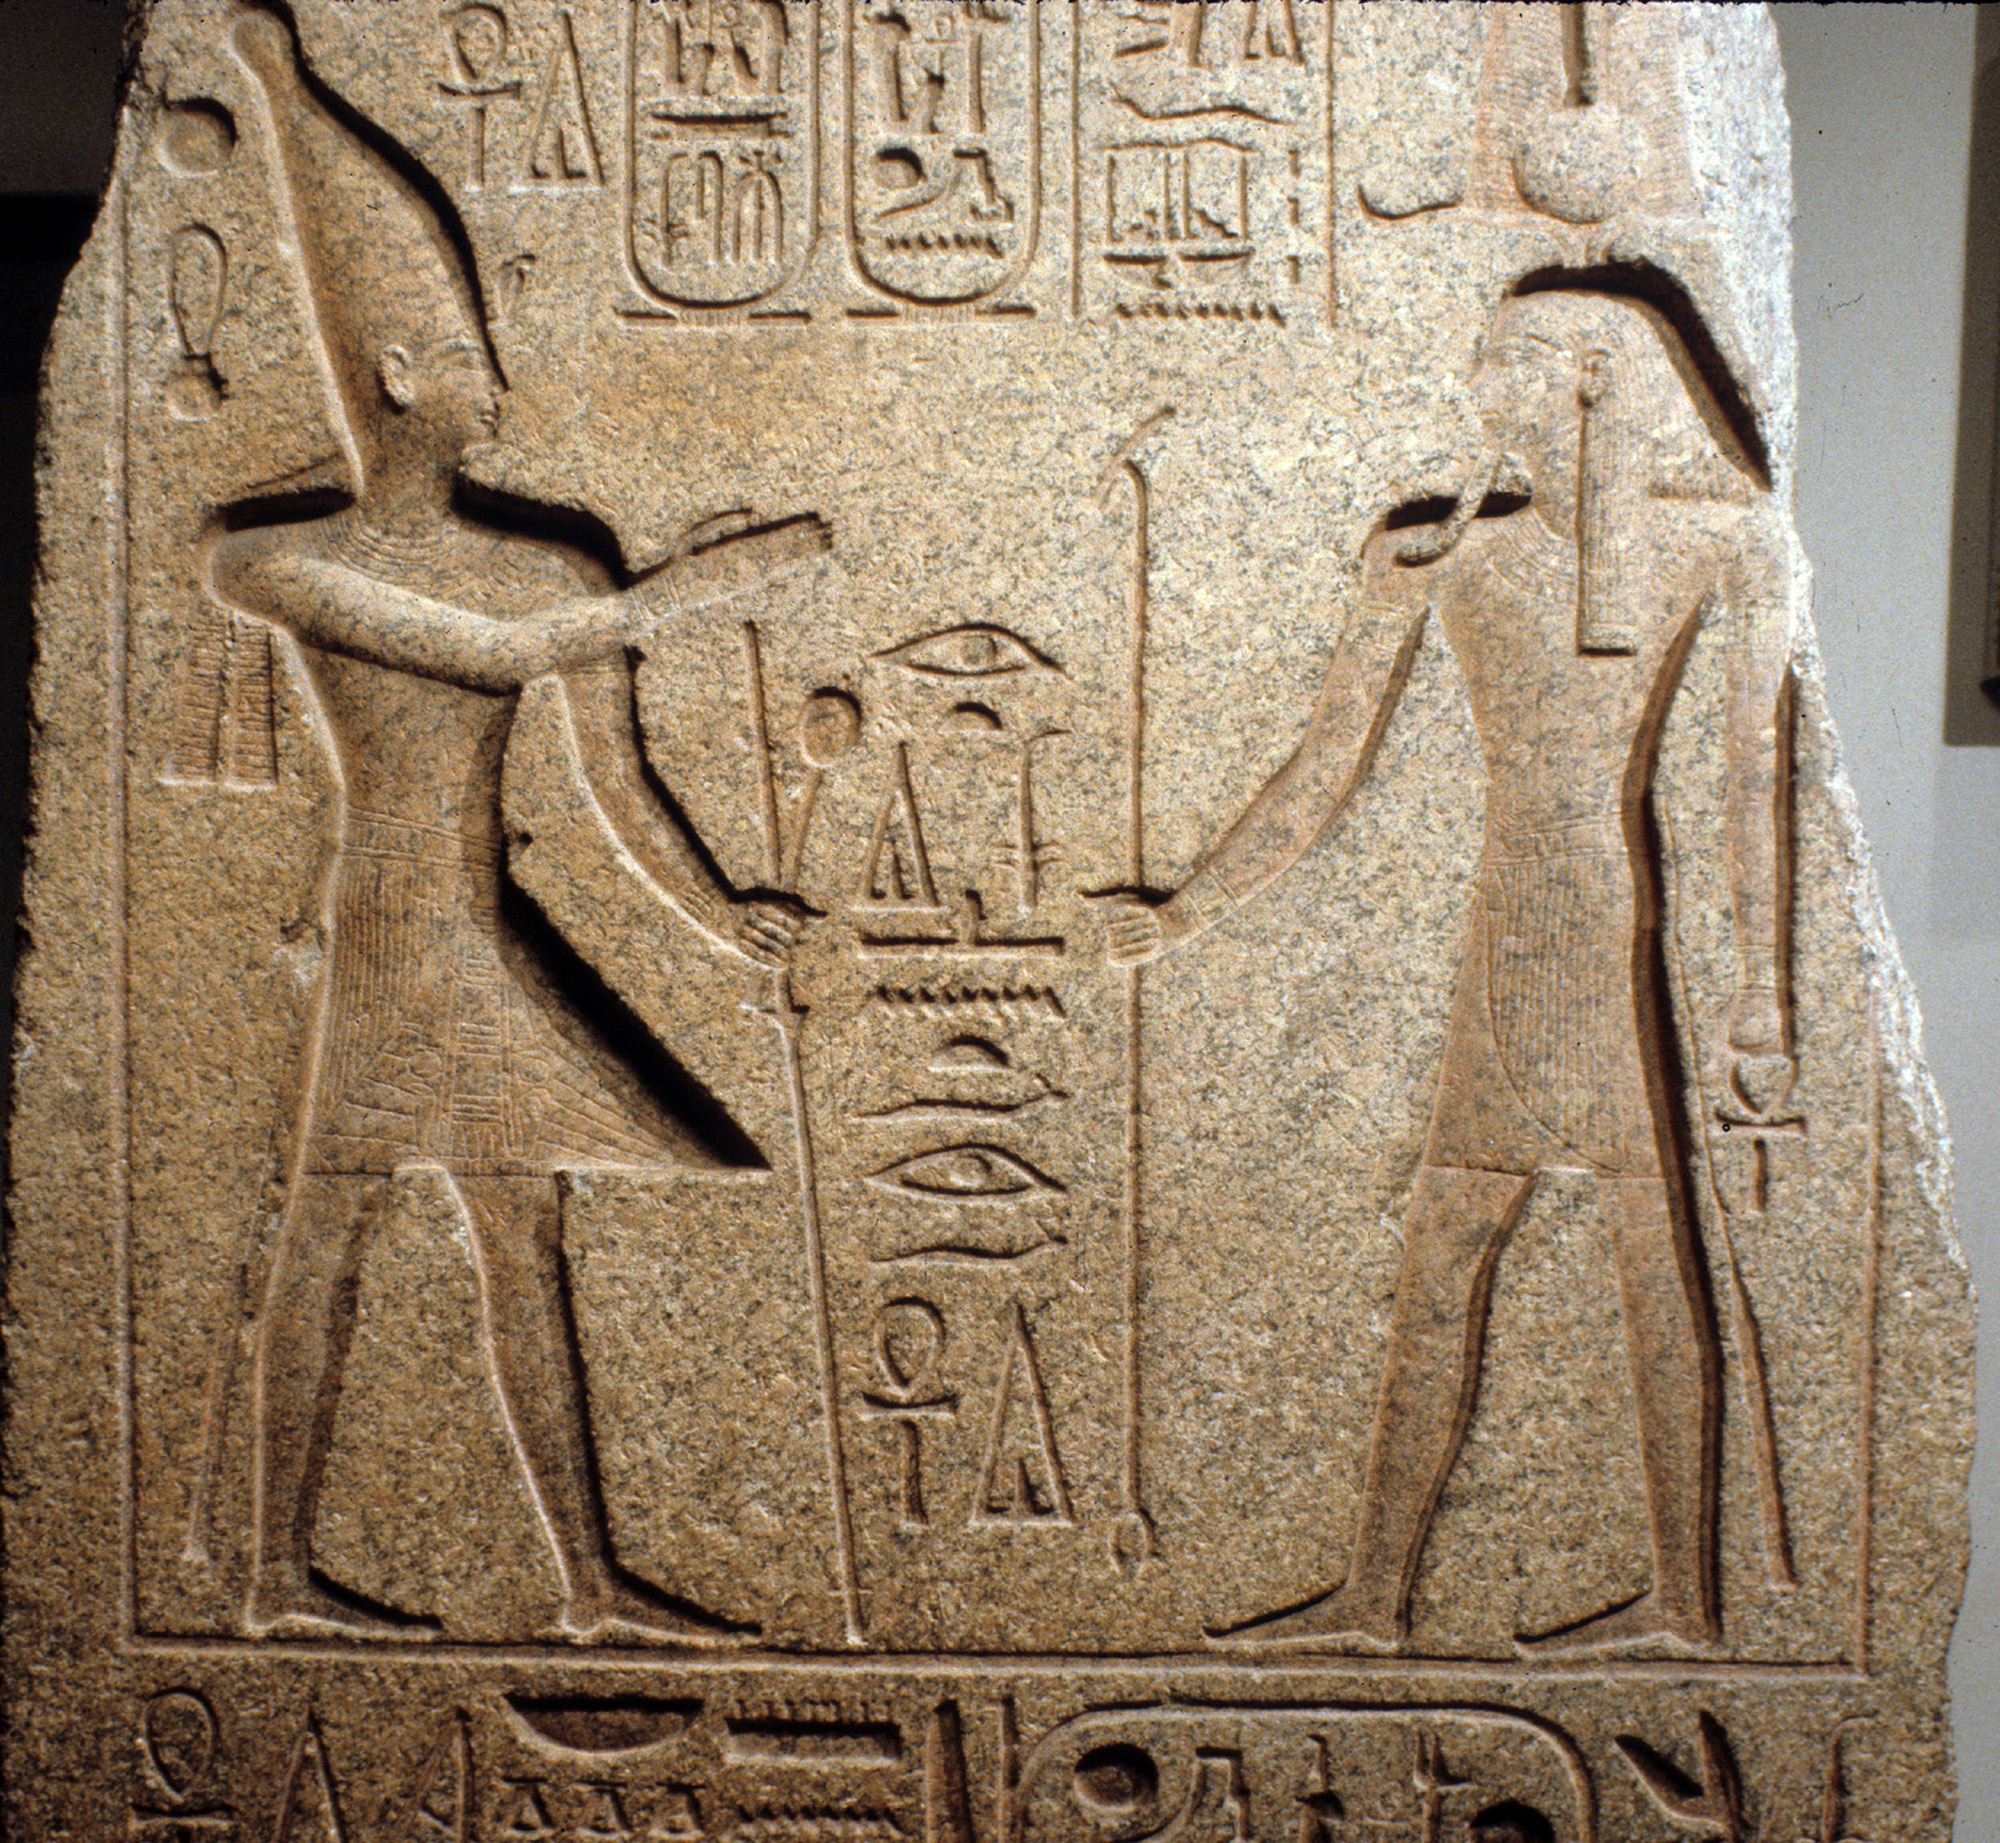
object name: door jamb, temple of ramesses ii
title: Doorjamb from a Temple of Ramesses II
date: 1279-1213 BCE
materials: granite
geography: egypt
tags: amun